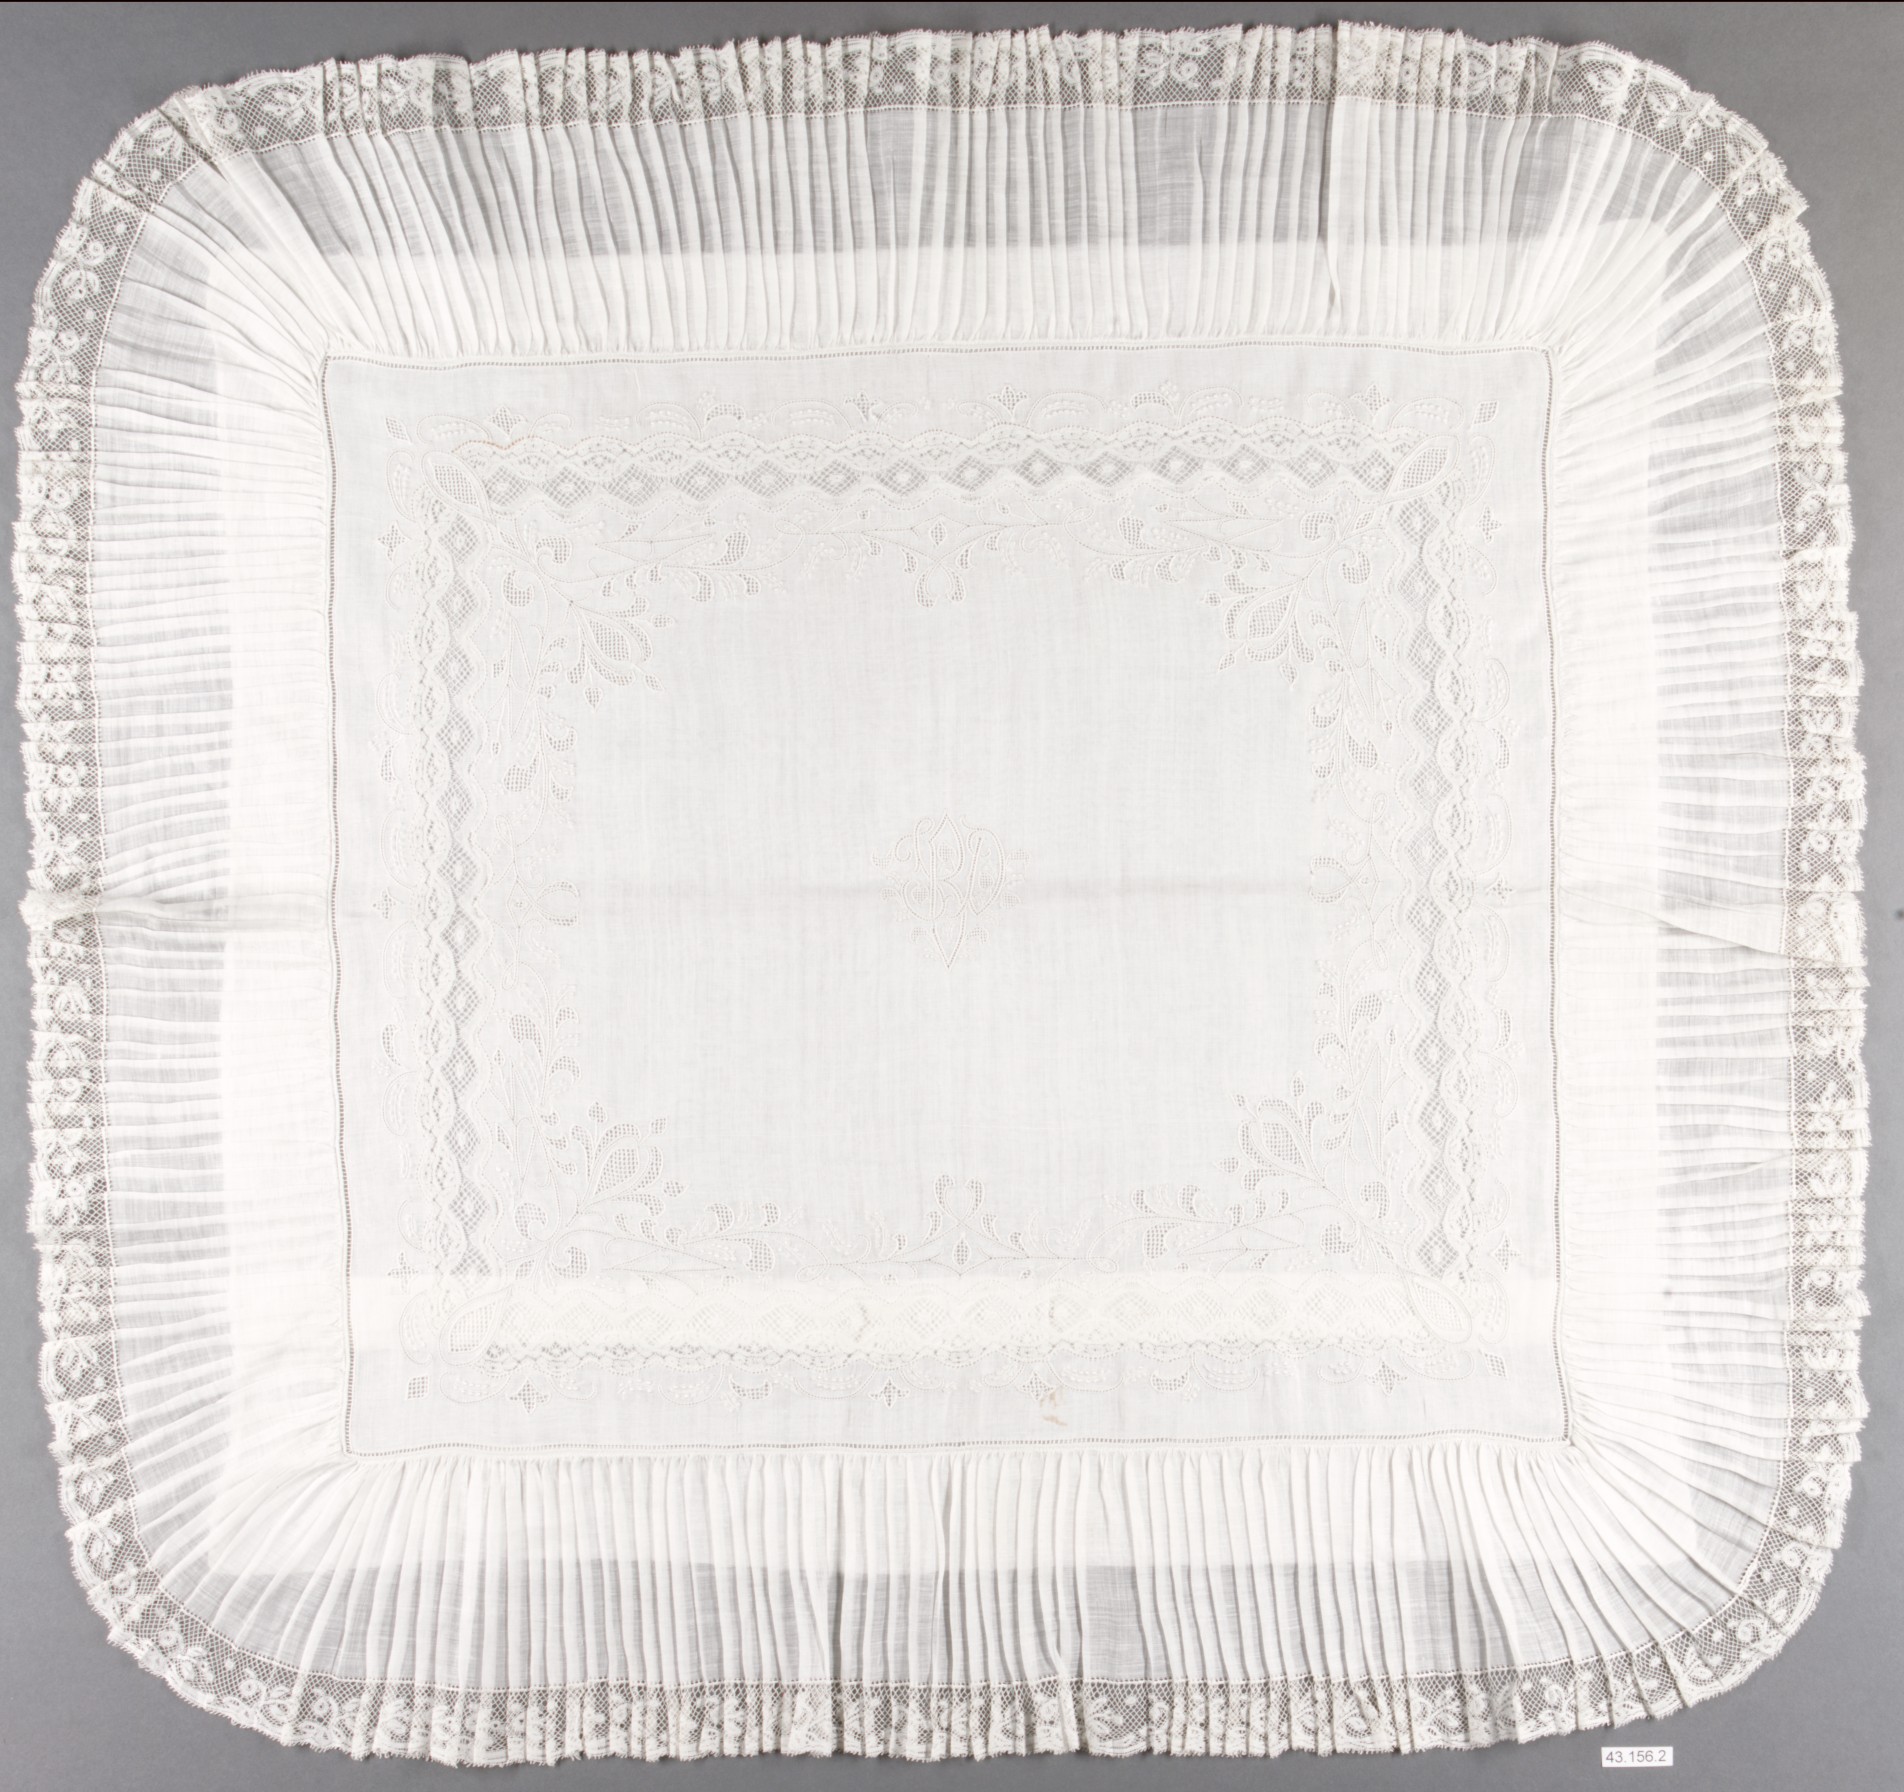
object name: pillowcase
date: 1890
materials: linen